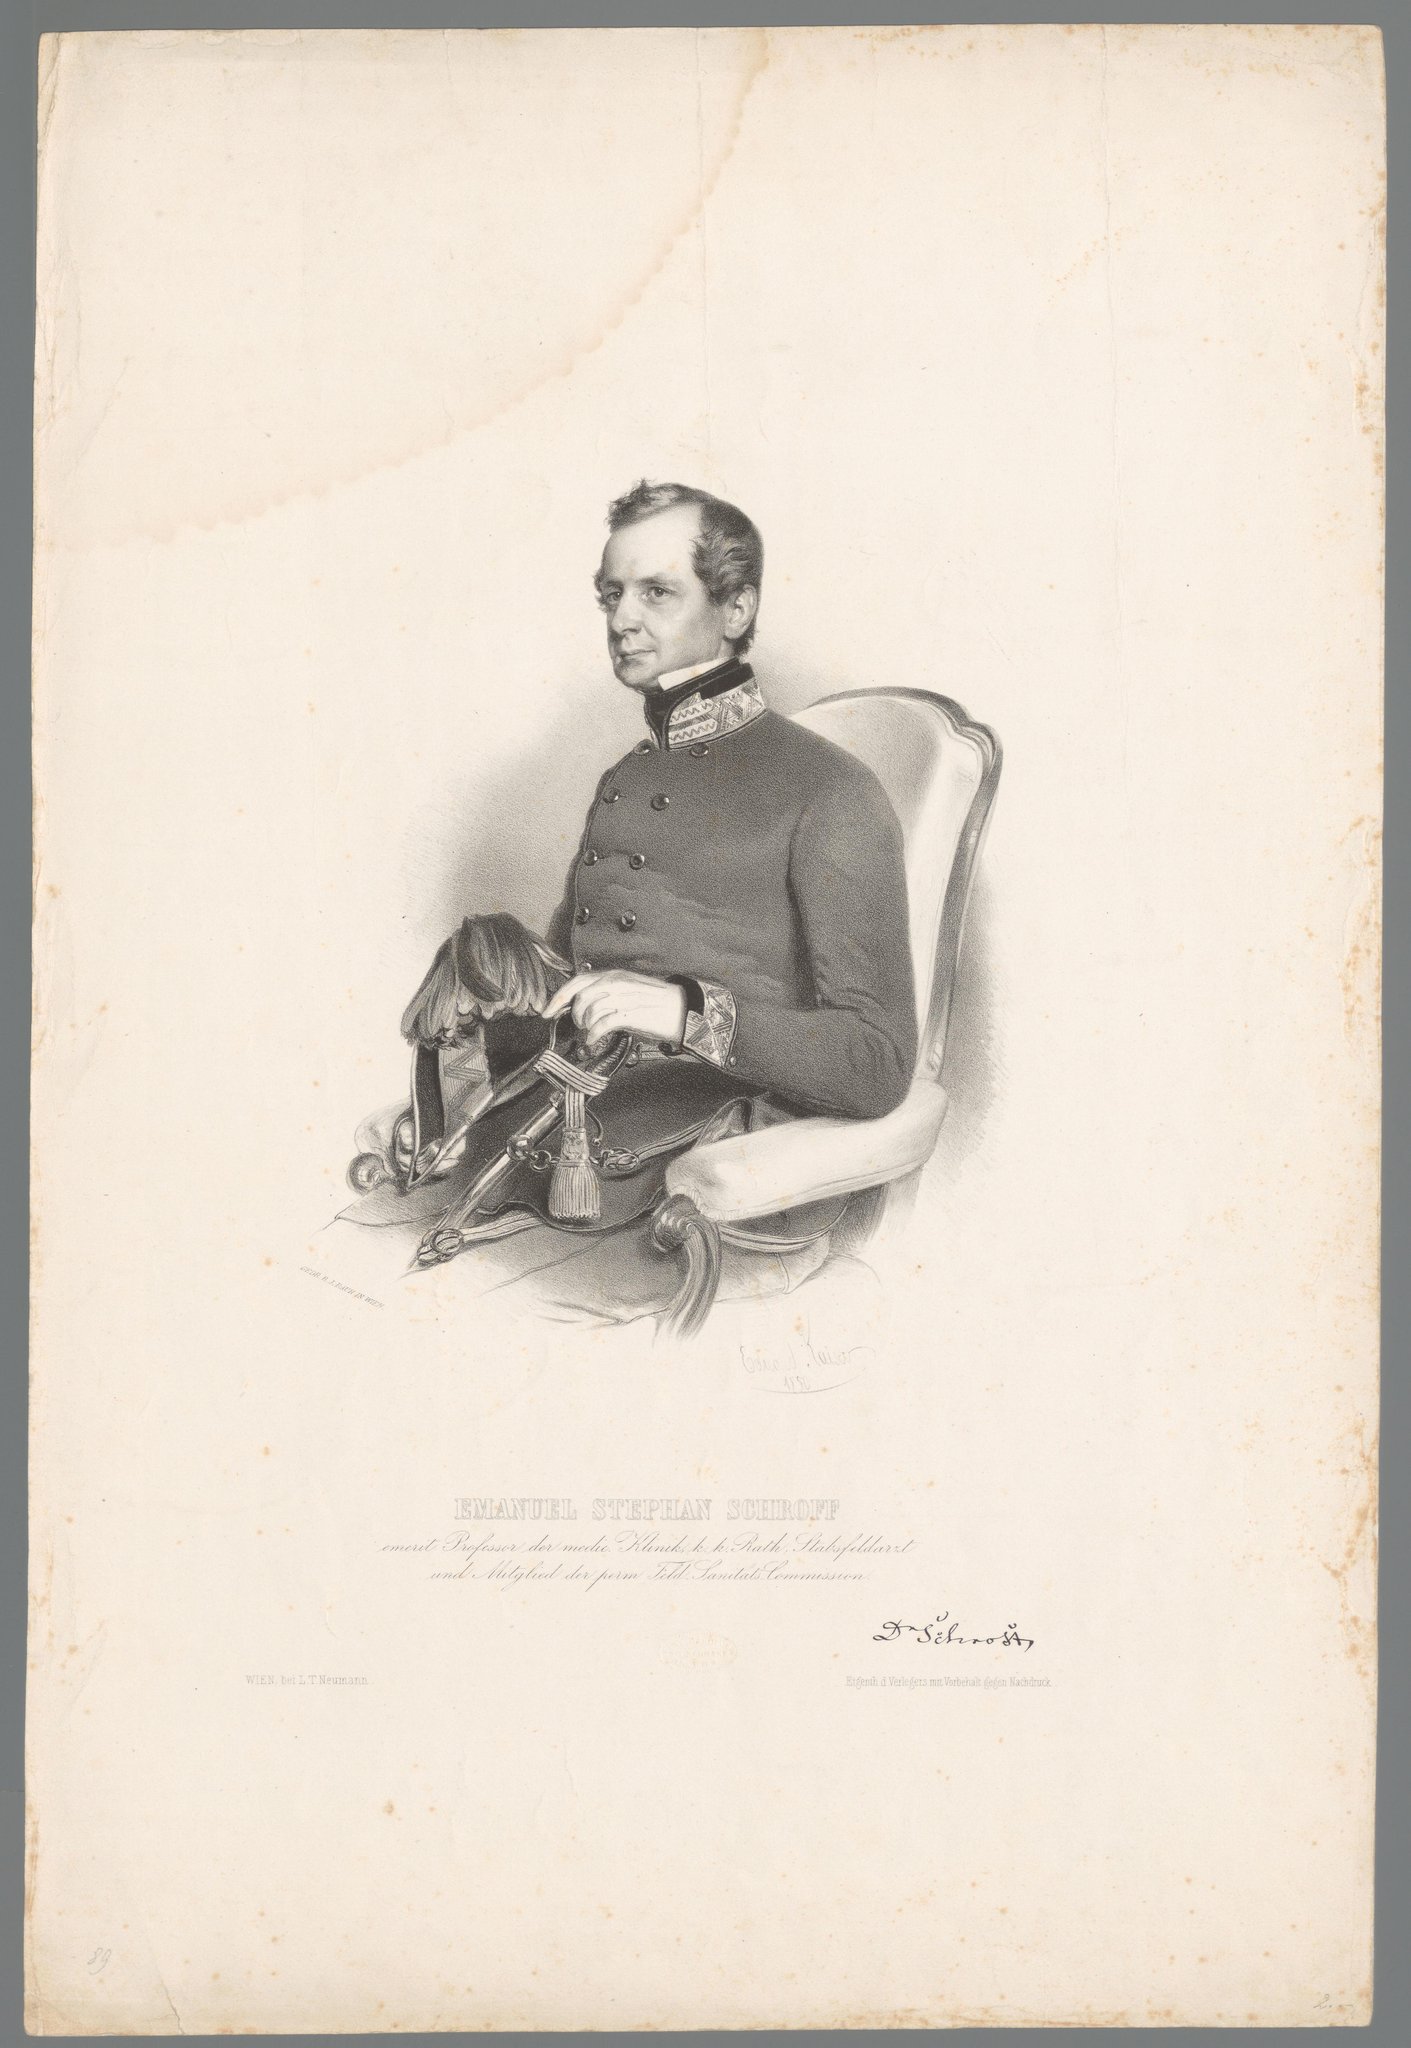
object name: print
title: Emanuel Stephan Schroff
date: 1850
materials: paper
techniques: lithograph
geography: vienna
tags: adult man, historical persons, (military) uniforms, chair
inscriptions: collector's mark: Lugt 2228, check stamp: ‘Kunsthandlung L.T. Neumann in Wien’